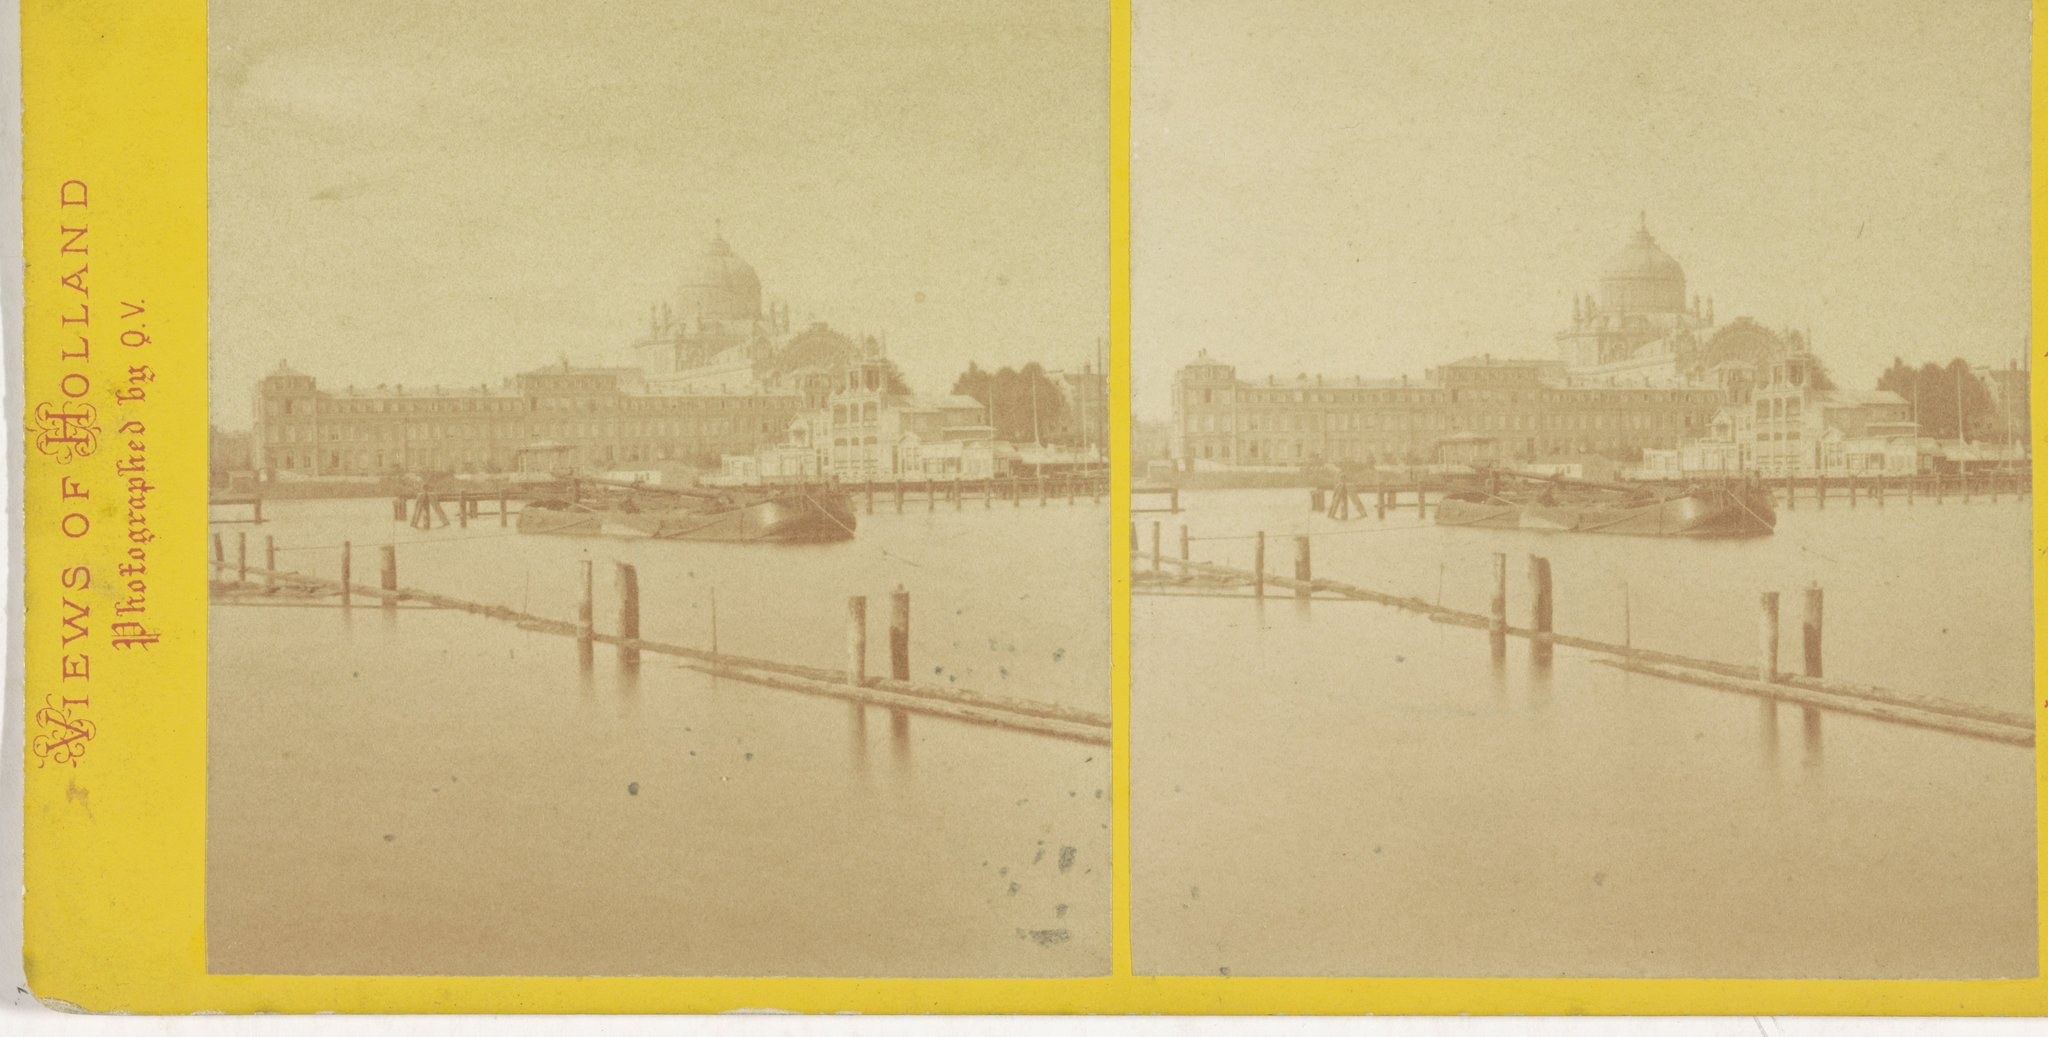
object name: stereograph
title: Gezicht op het Paleis voor Volksvlijt te Amsterdam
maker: jules hippolyte quéval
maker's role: publisher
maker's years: 1824-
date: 1860-1880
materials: cardboard, paper, photographic support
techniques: albumen print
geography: amsterdam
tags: amsterdam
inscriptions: title: ‘Nº 2105 Amsterdam / Le bâtiment des Régates et le Palais de l'Industrie.’, number: ‘50 (?)’, title: ‘La Hollande’, title: ‘Views of Holland’